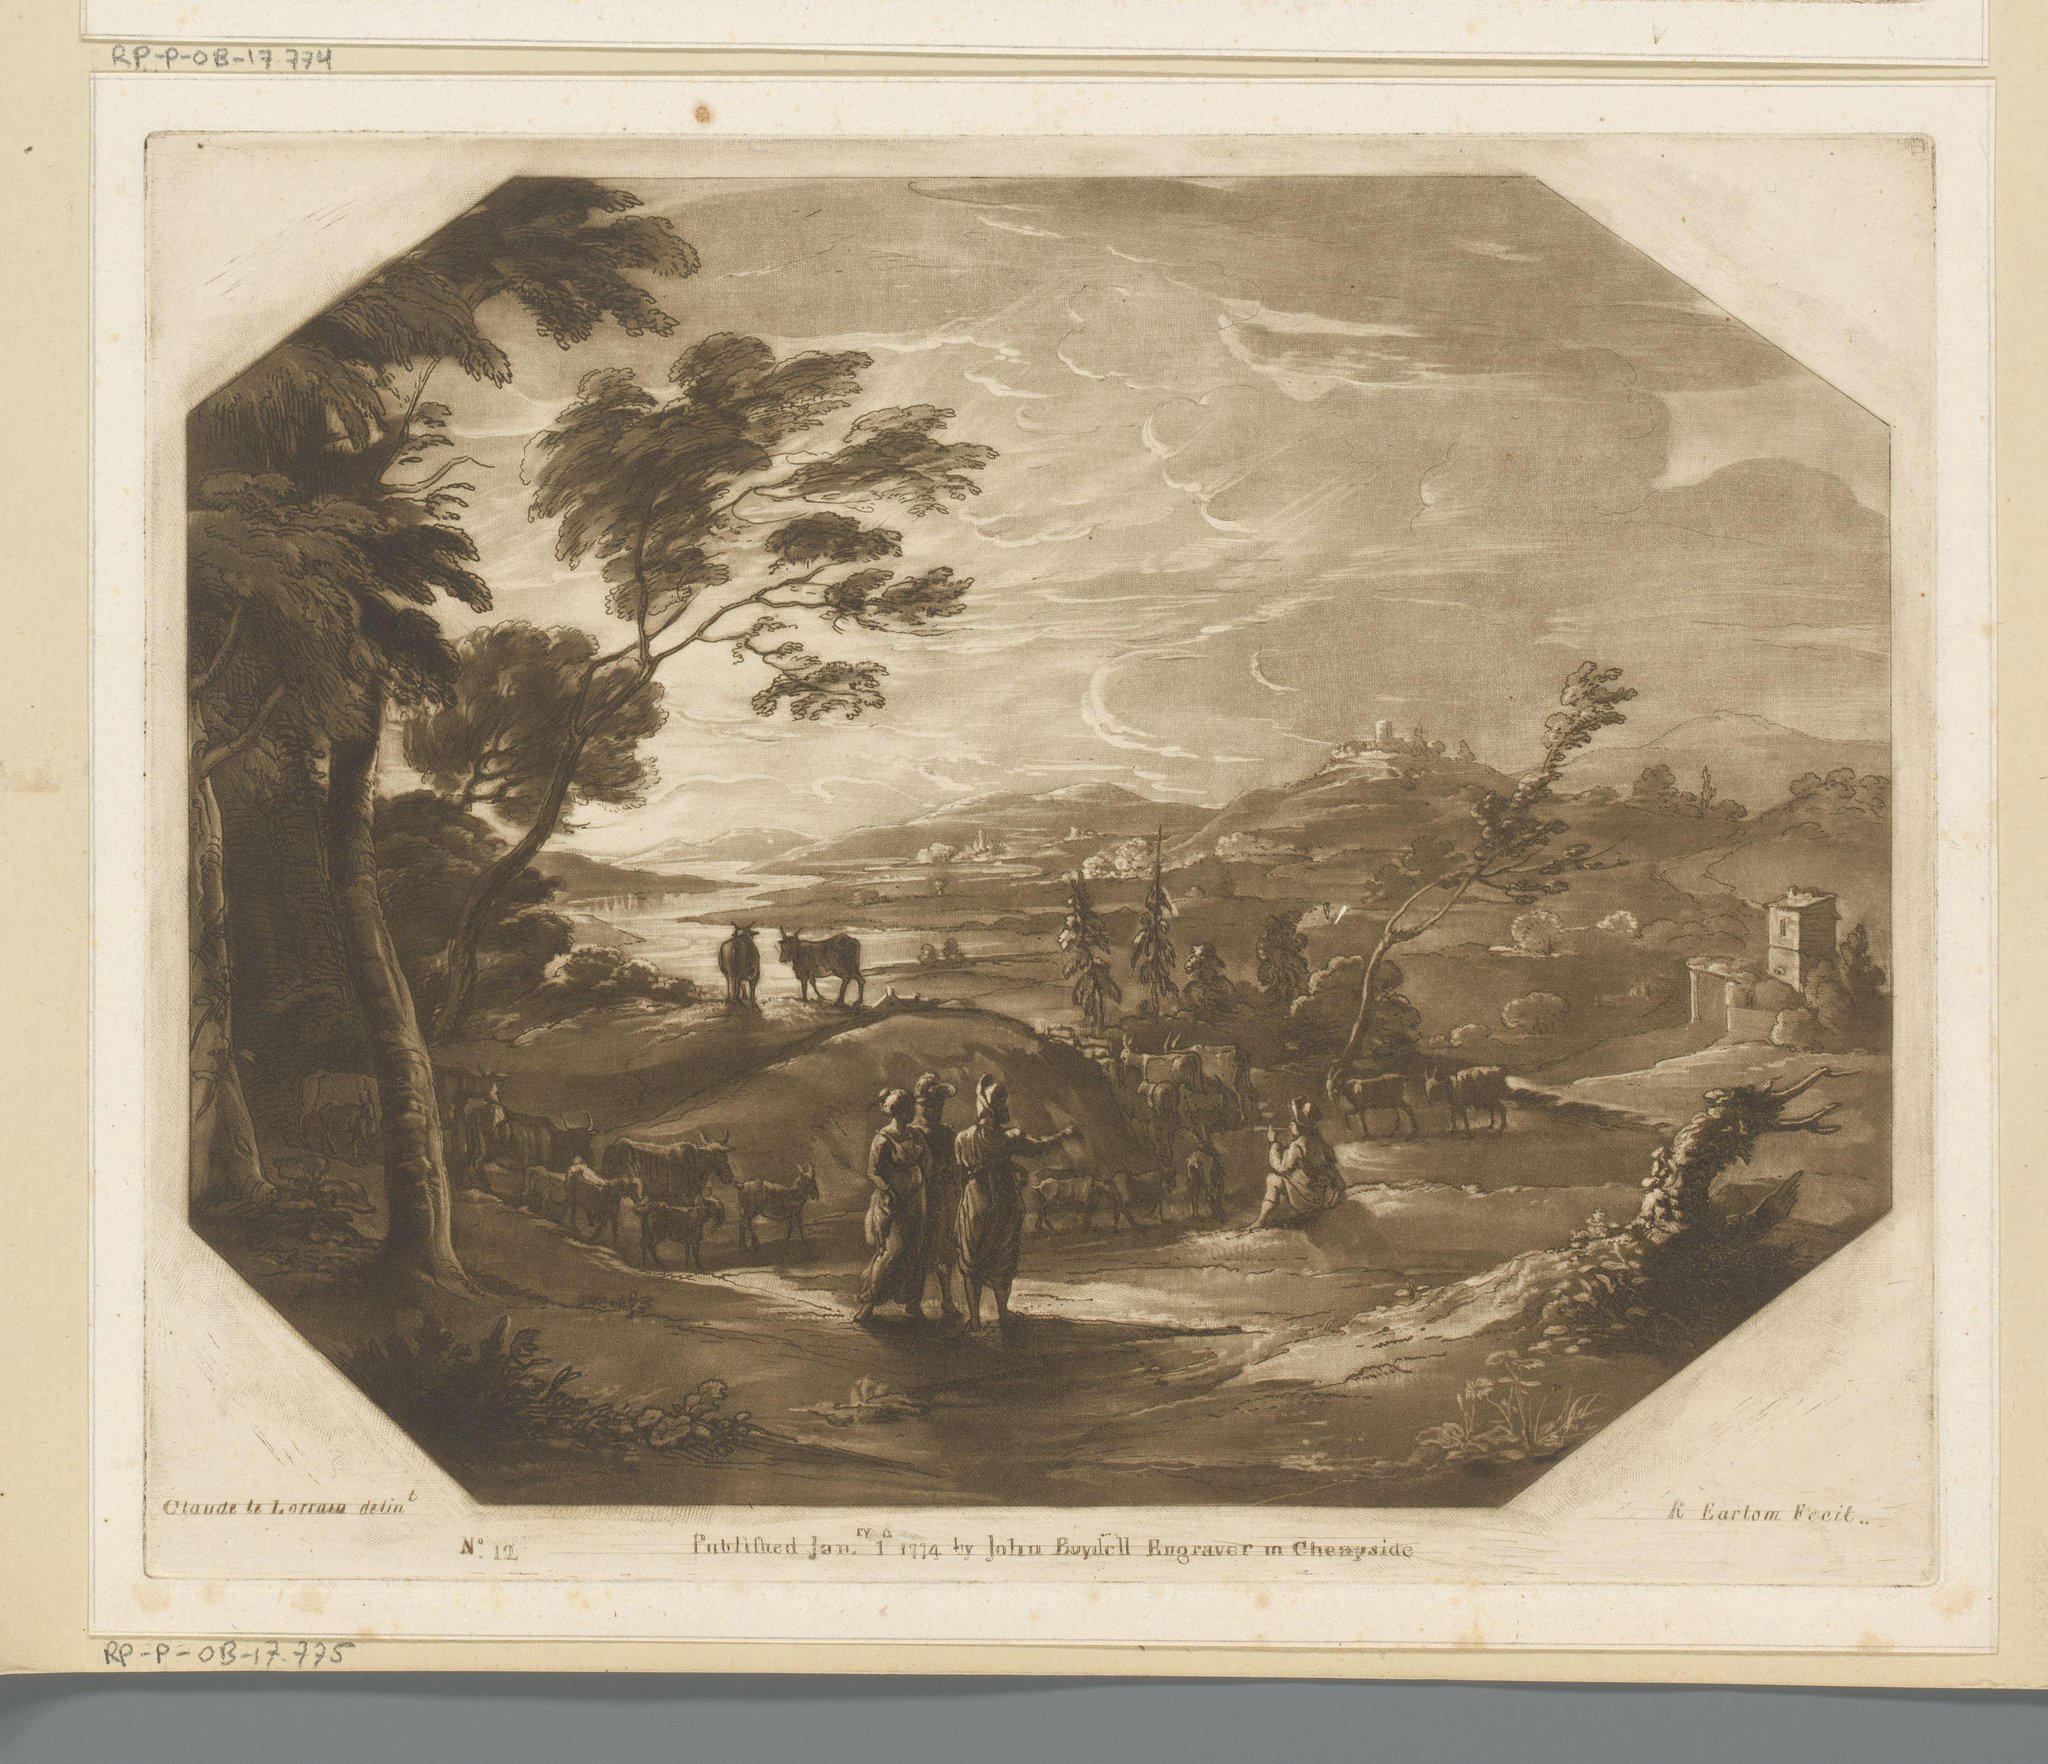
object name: print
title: Prenten naar tekeningen van Claude Lorrain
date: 1774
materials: paper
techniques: etching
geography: london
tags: herding, herdsman, herdswoman, shepherd, shepherdess, cowherd, etc., cattle, (high) hill, sunrise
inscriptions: date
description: Vanaf 1774 publiceerde John Boydell tweehonderd prenten naar het tekeningenboek Liber Veritatis van Claude Lorrain, in het bezit van de hertogen van Cavendish. Deze werden vanaf 1777 in twee volumes gebundeld uitgegeven.